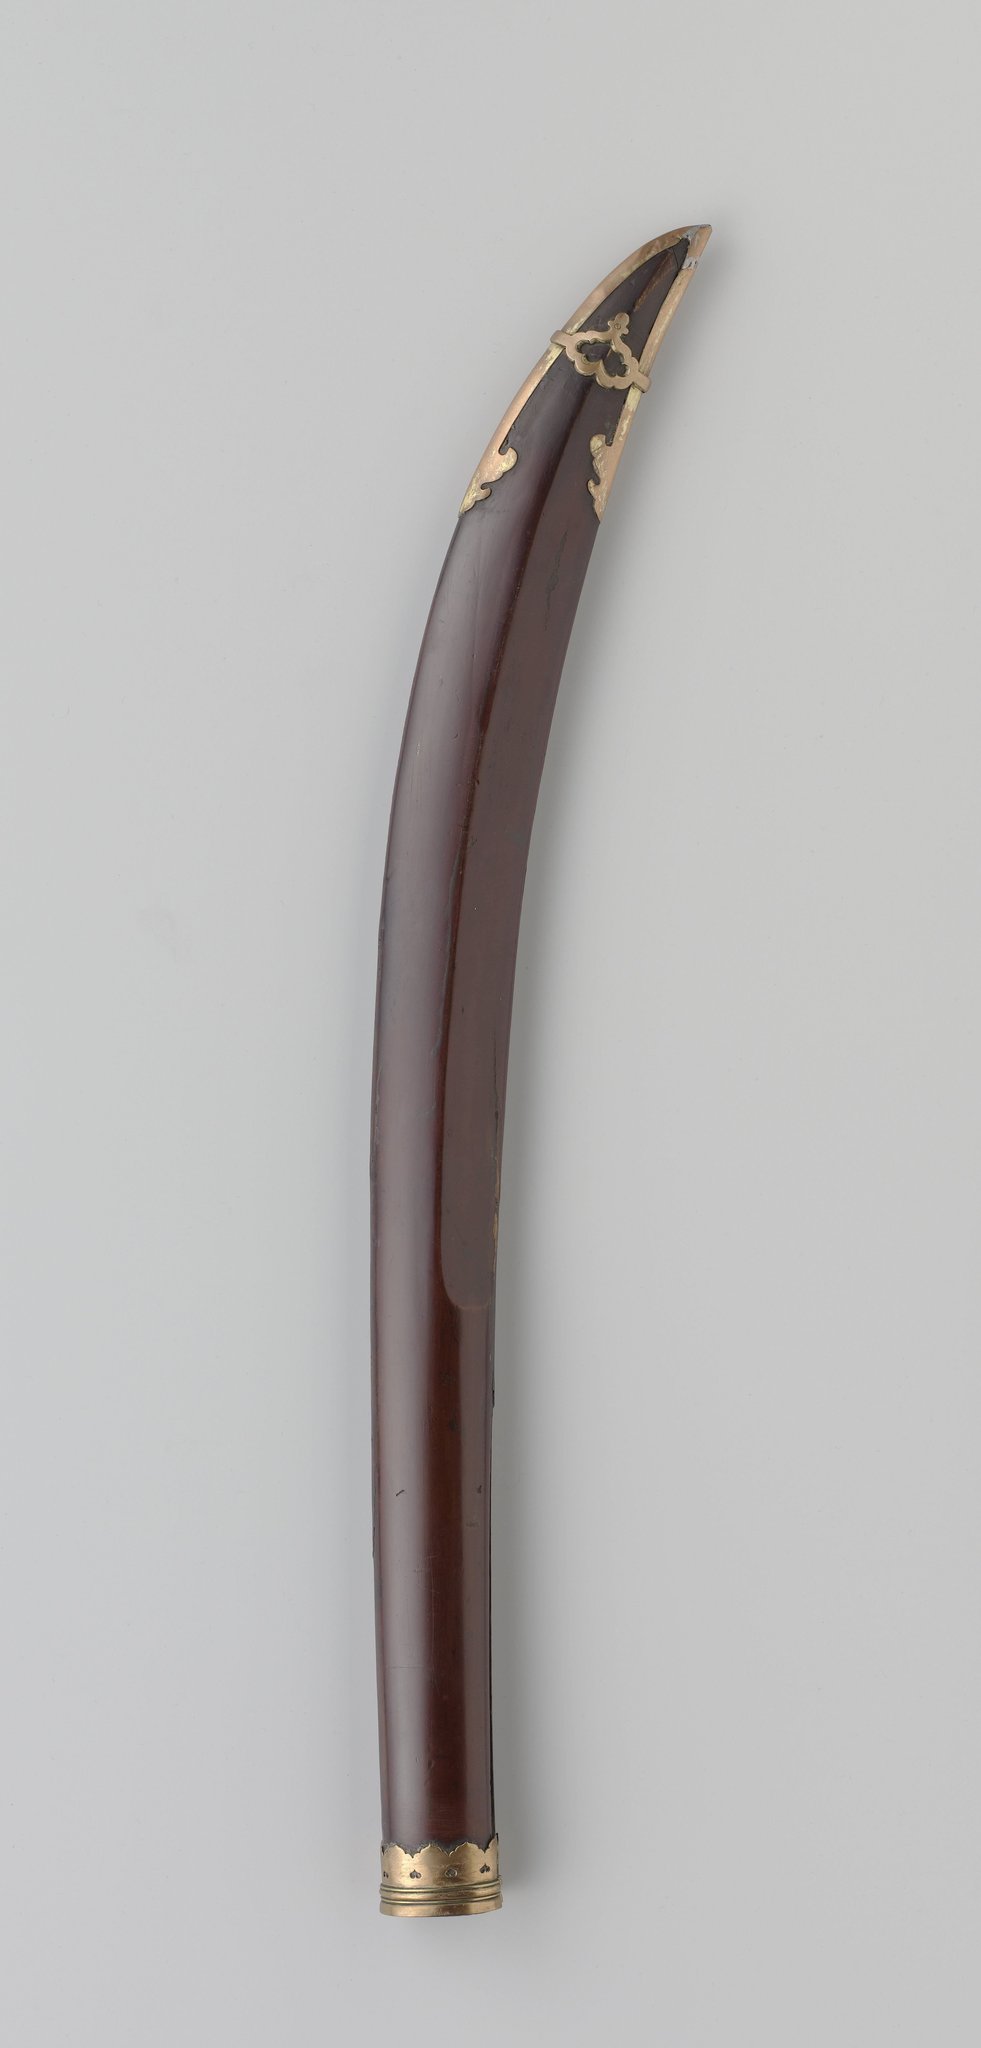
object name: knife with sheath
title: Schede van lans van Cornelis Tromp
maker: Anonymous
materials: brass, copper, wood, lacquer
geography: japan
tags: rotterdam, amsterdam, cornelis tromp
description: Arms rack. This arms rack of katsura wood stood in the Amsterdam home of Cornelis Tromp (1629-1691). It may have been given by the VOC. In the 17th century this was known as the East-Indian gun case. It was probably made by Chinese craftsmen working on the northern coast of Java in the 17th or 18th century. The arms rack is decorated with birds and flowers. The swords and lances are Japanese in shape. The blades and some of the mounts were certainly made in Japan.